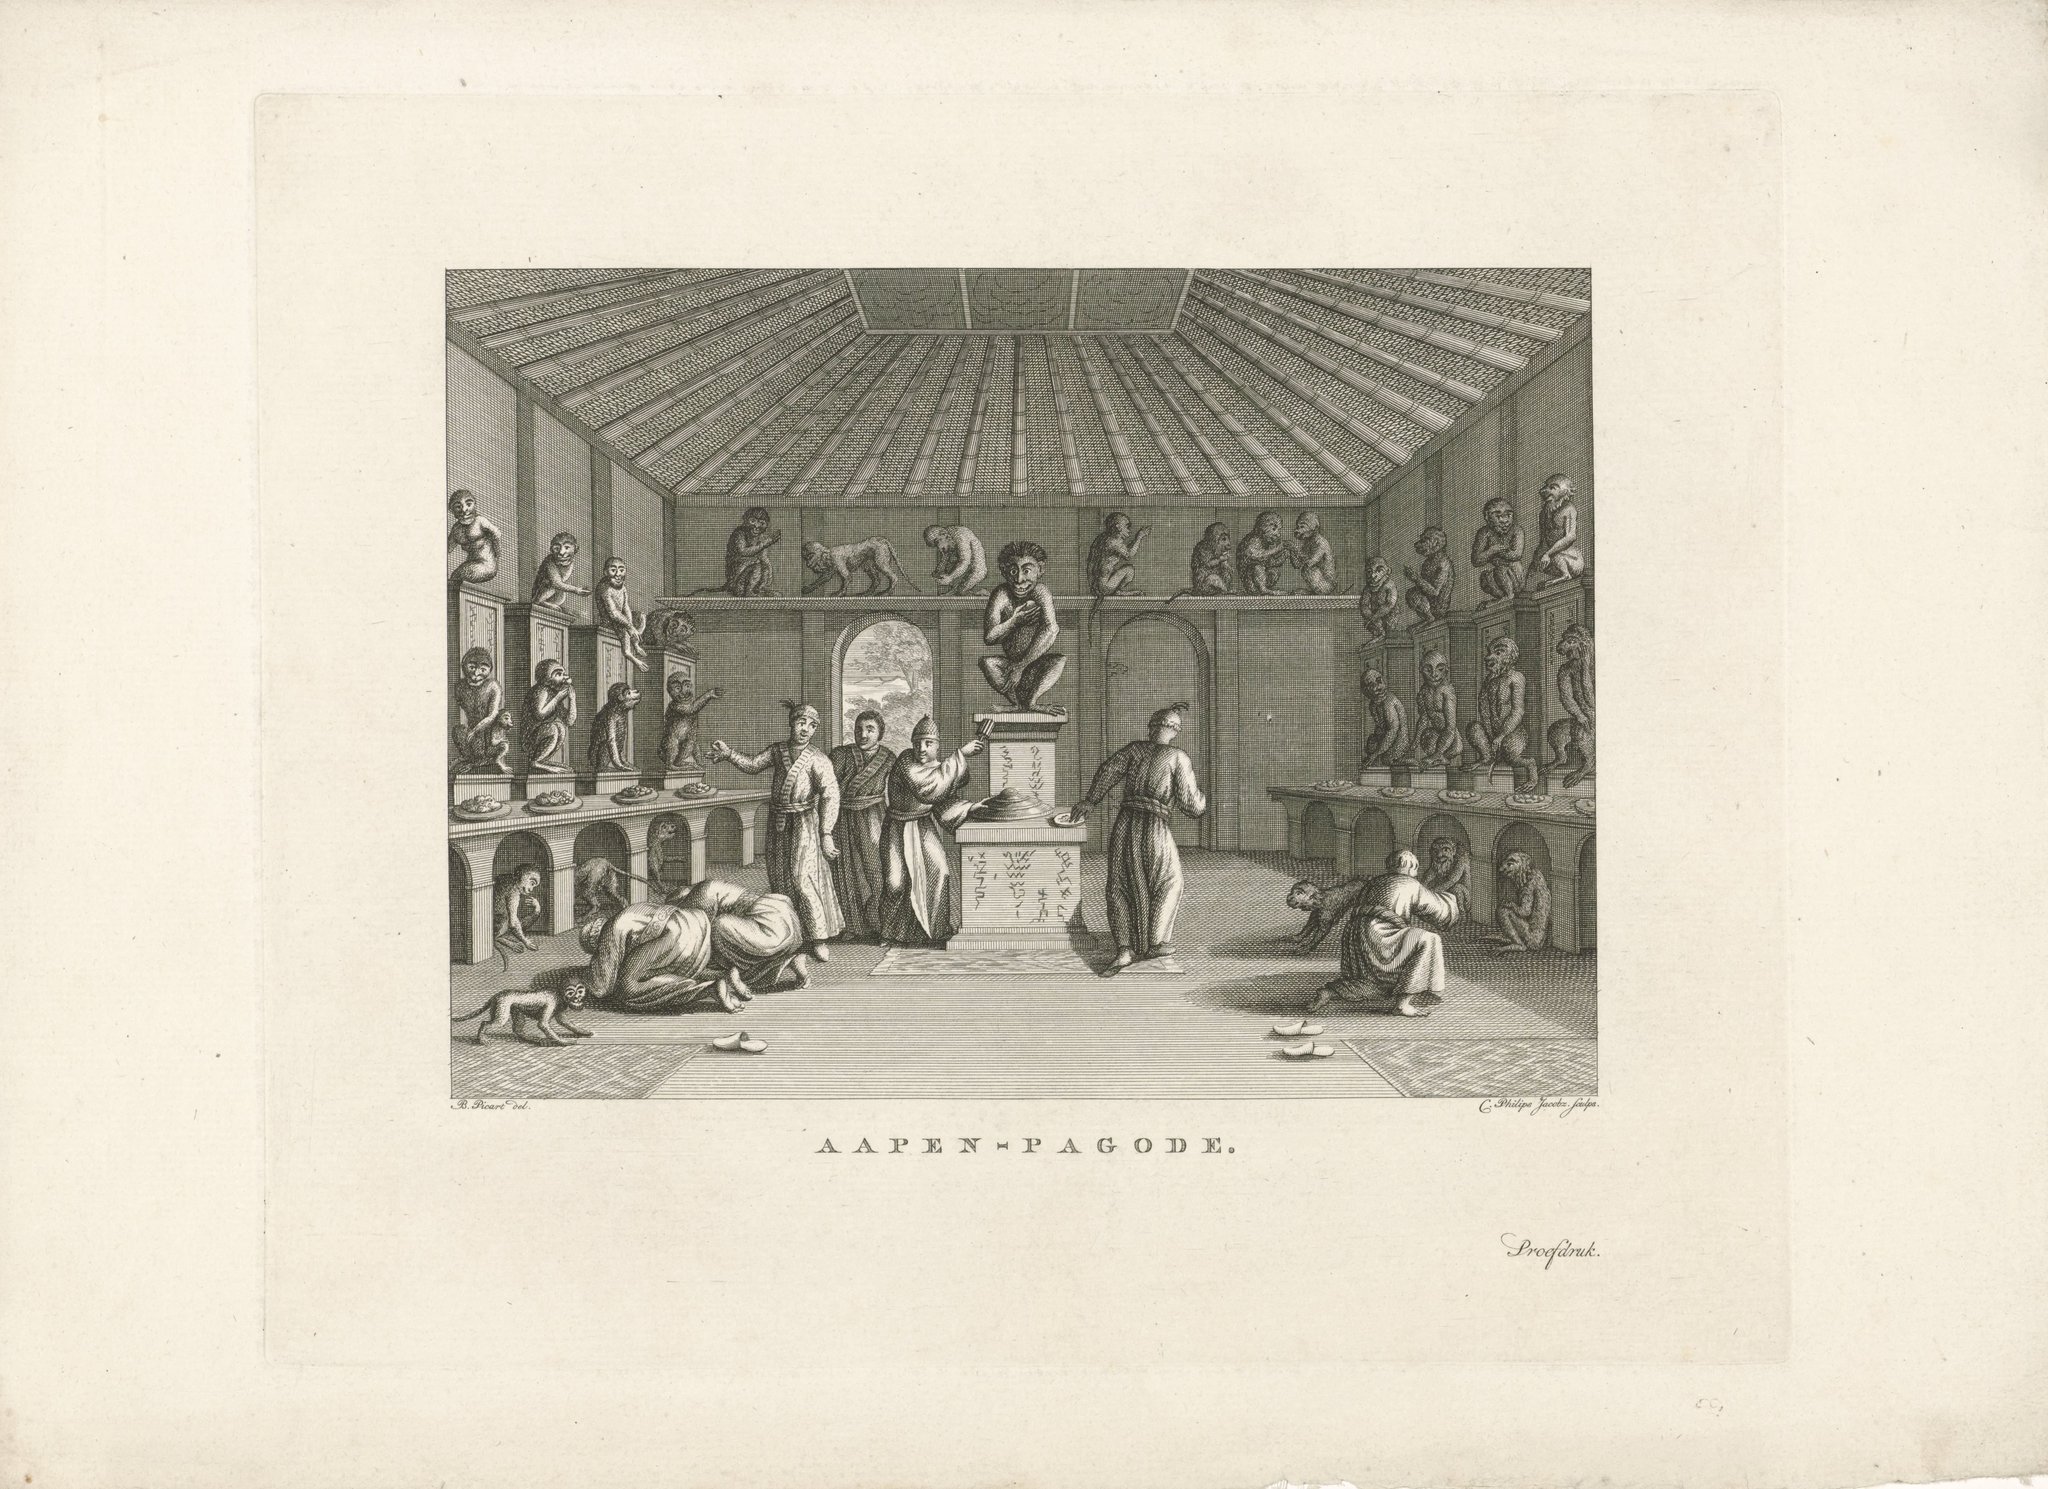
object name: print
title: Aapen-pagode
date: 1752-1789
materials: paper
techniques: etching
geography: amsterdam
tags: temple, shrine ~ shinto, monkeys, apes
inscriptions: collector's mark: Lugt 2228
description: Interieur van een Japanse tempel, in het midden een standbeeld van een aap op een sokkel waarop Japanse tekens. De tempel wordt bezocht door mannen, van wie twee in aanbidding knielen voor de apen die zich langs de wanden hebben geschaard.